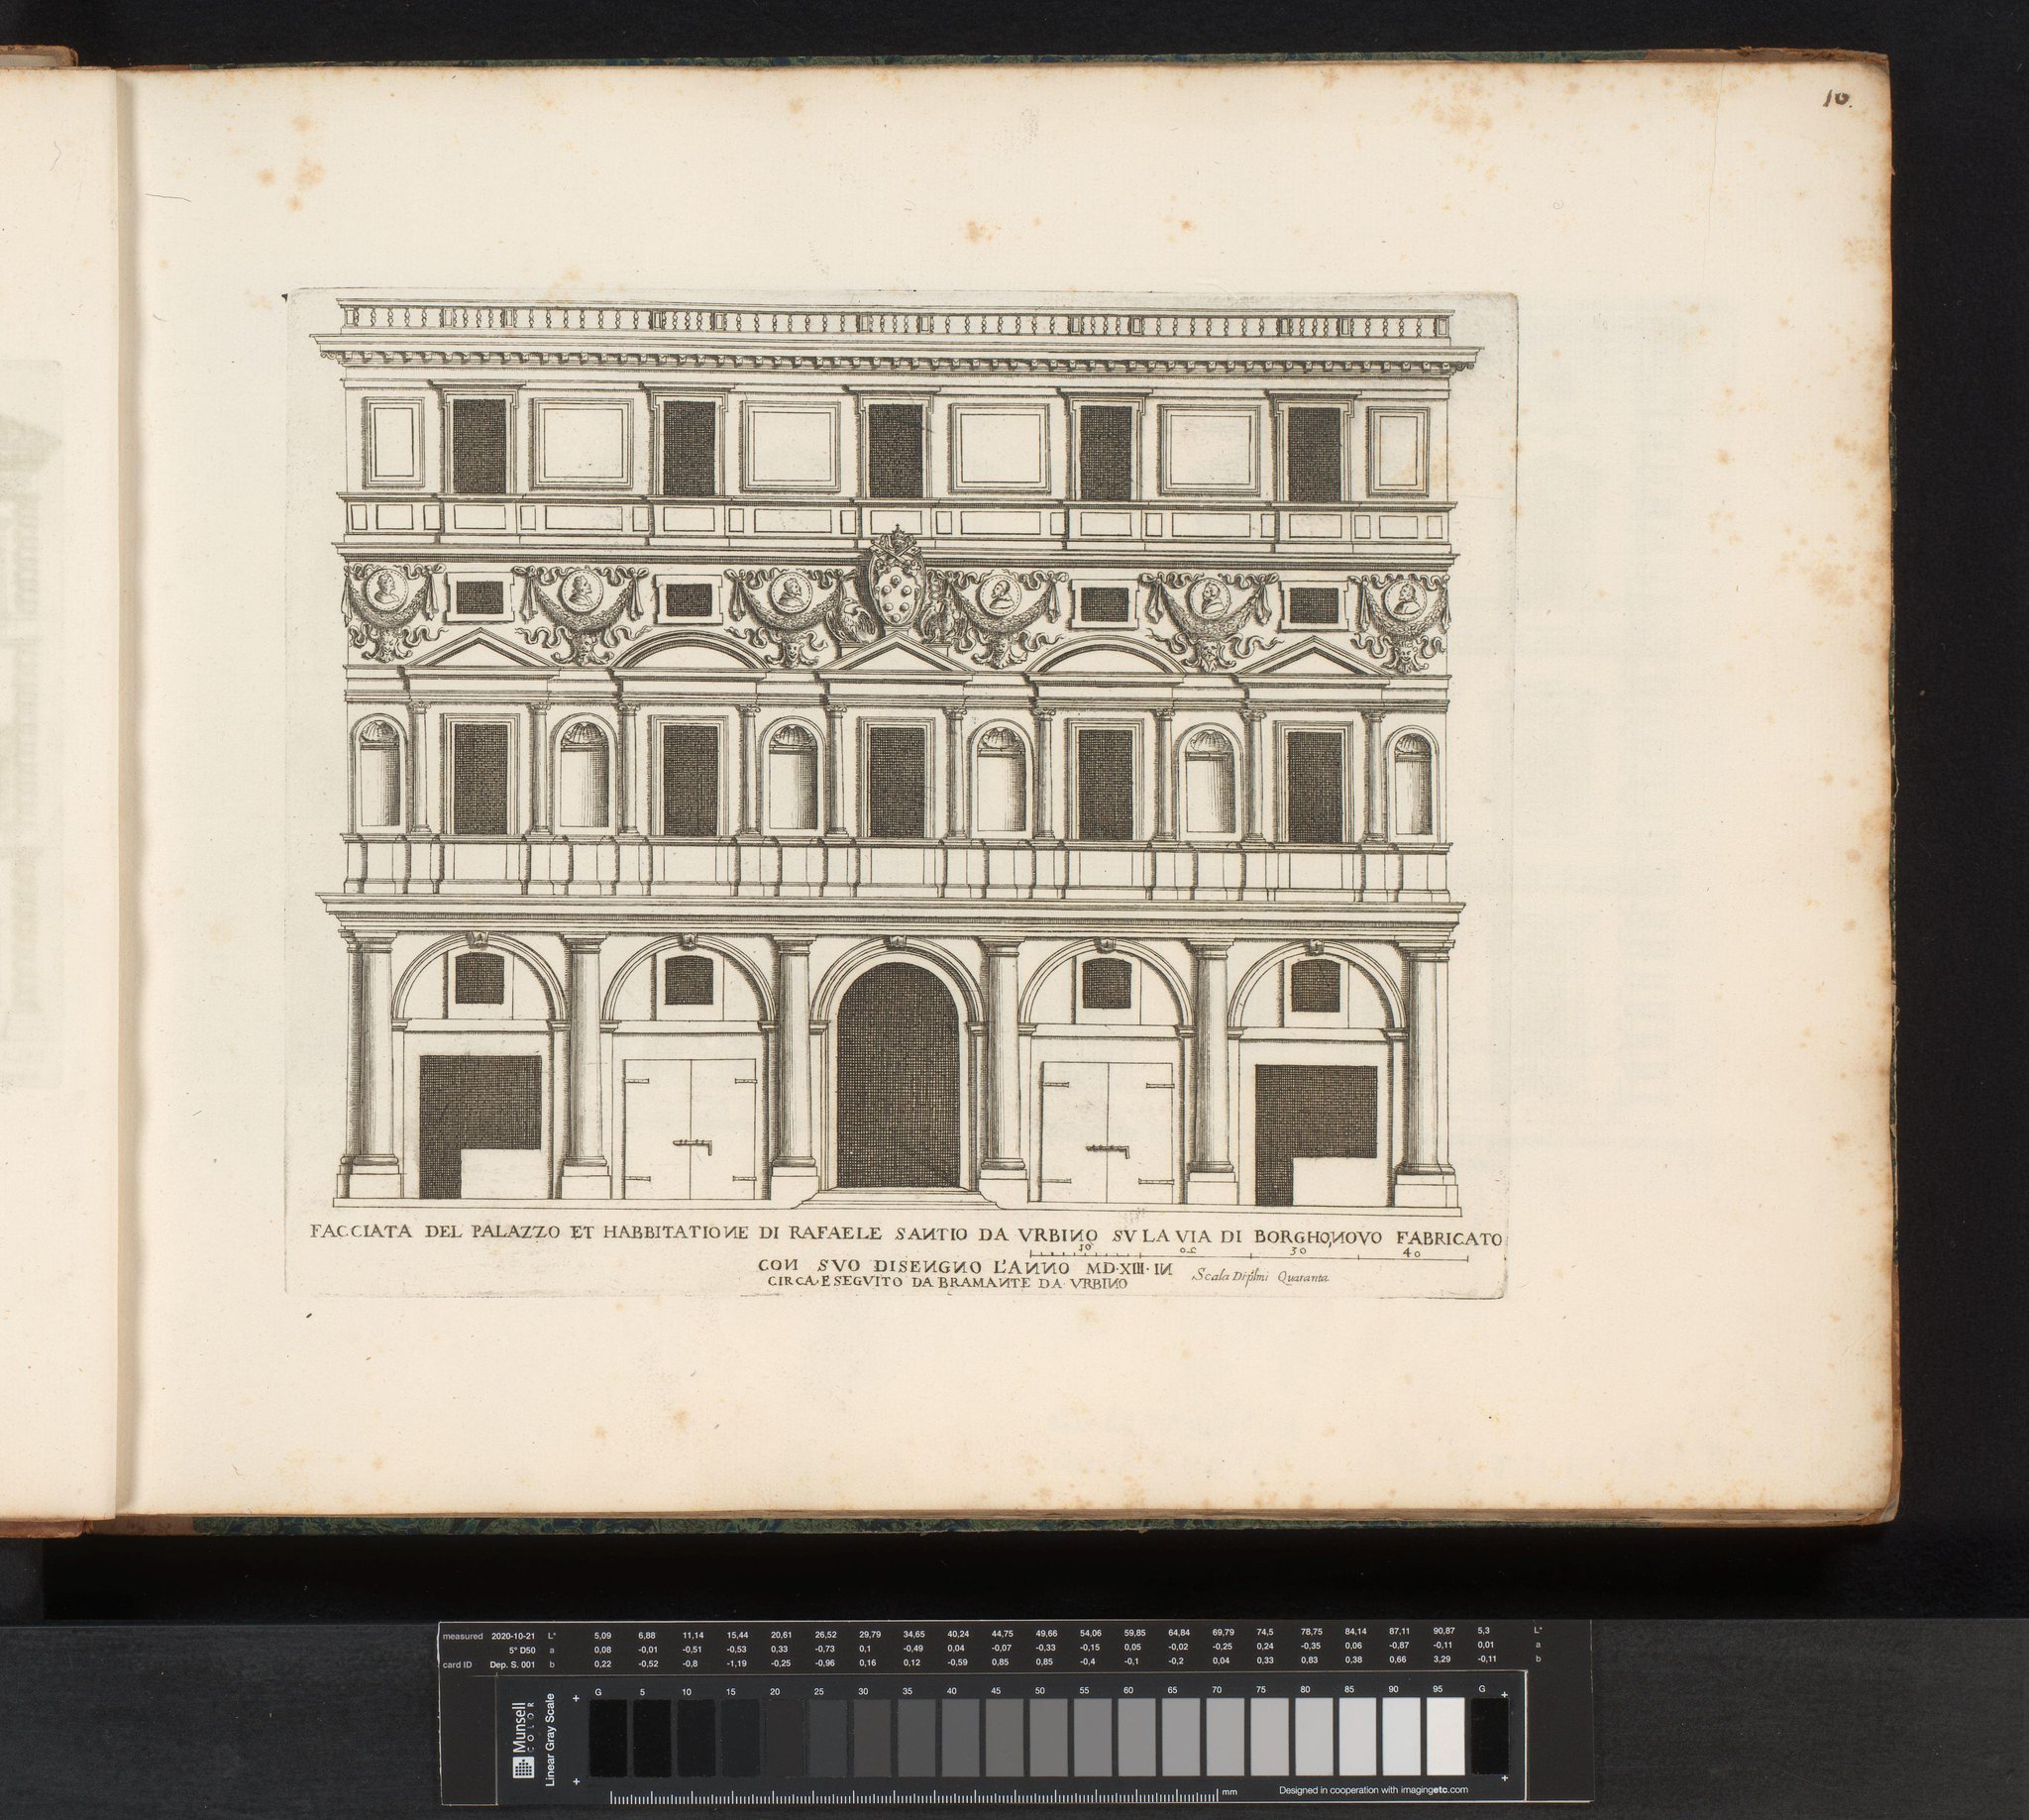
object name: album leaf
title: Romeinse paleizen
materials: paper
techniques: etching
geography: rome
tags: palace, façade (of house or building)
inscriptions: number: ‘10’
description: Deze prent maakt deel uit van de reeks getiteld: Palazzi di Roma. Deze reeks bestaat uit twee boeken. Boek één getiteld: Palazzi di Roma dei più celebri architetti..., bestaat uit 44 prenten die worden toegeschreven aan Giovanni Battista Falda (naam staat enkel op prent 27) en uitgegeven door Giovanni Giacomo de'Rossi. Deze 44 prenten zijn bekend in twee staten (met en zonder nummer). Boek twee getiteld: Nuovi disegni dell'architetture... libro secondo, bevat 66 prenten door Giovanni Battista Falda en Simone Felice. Deze 66 prenten zijn bekend in twee staten (met en zonder nummer).